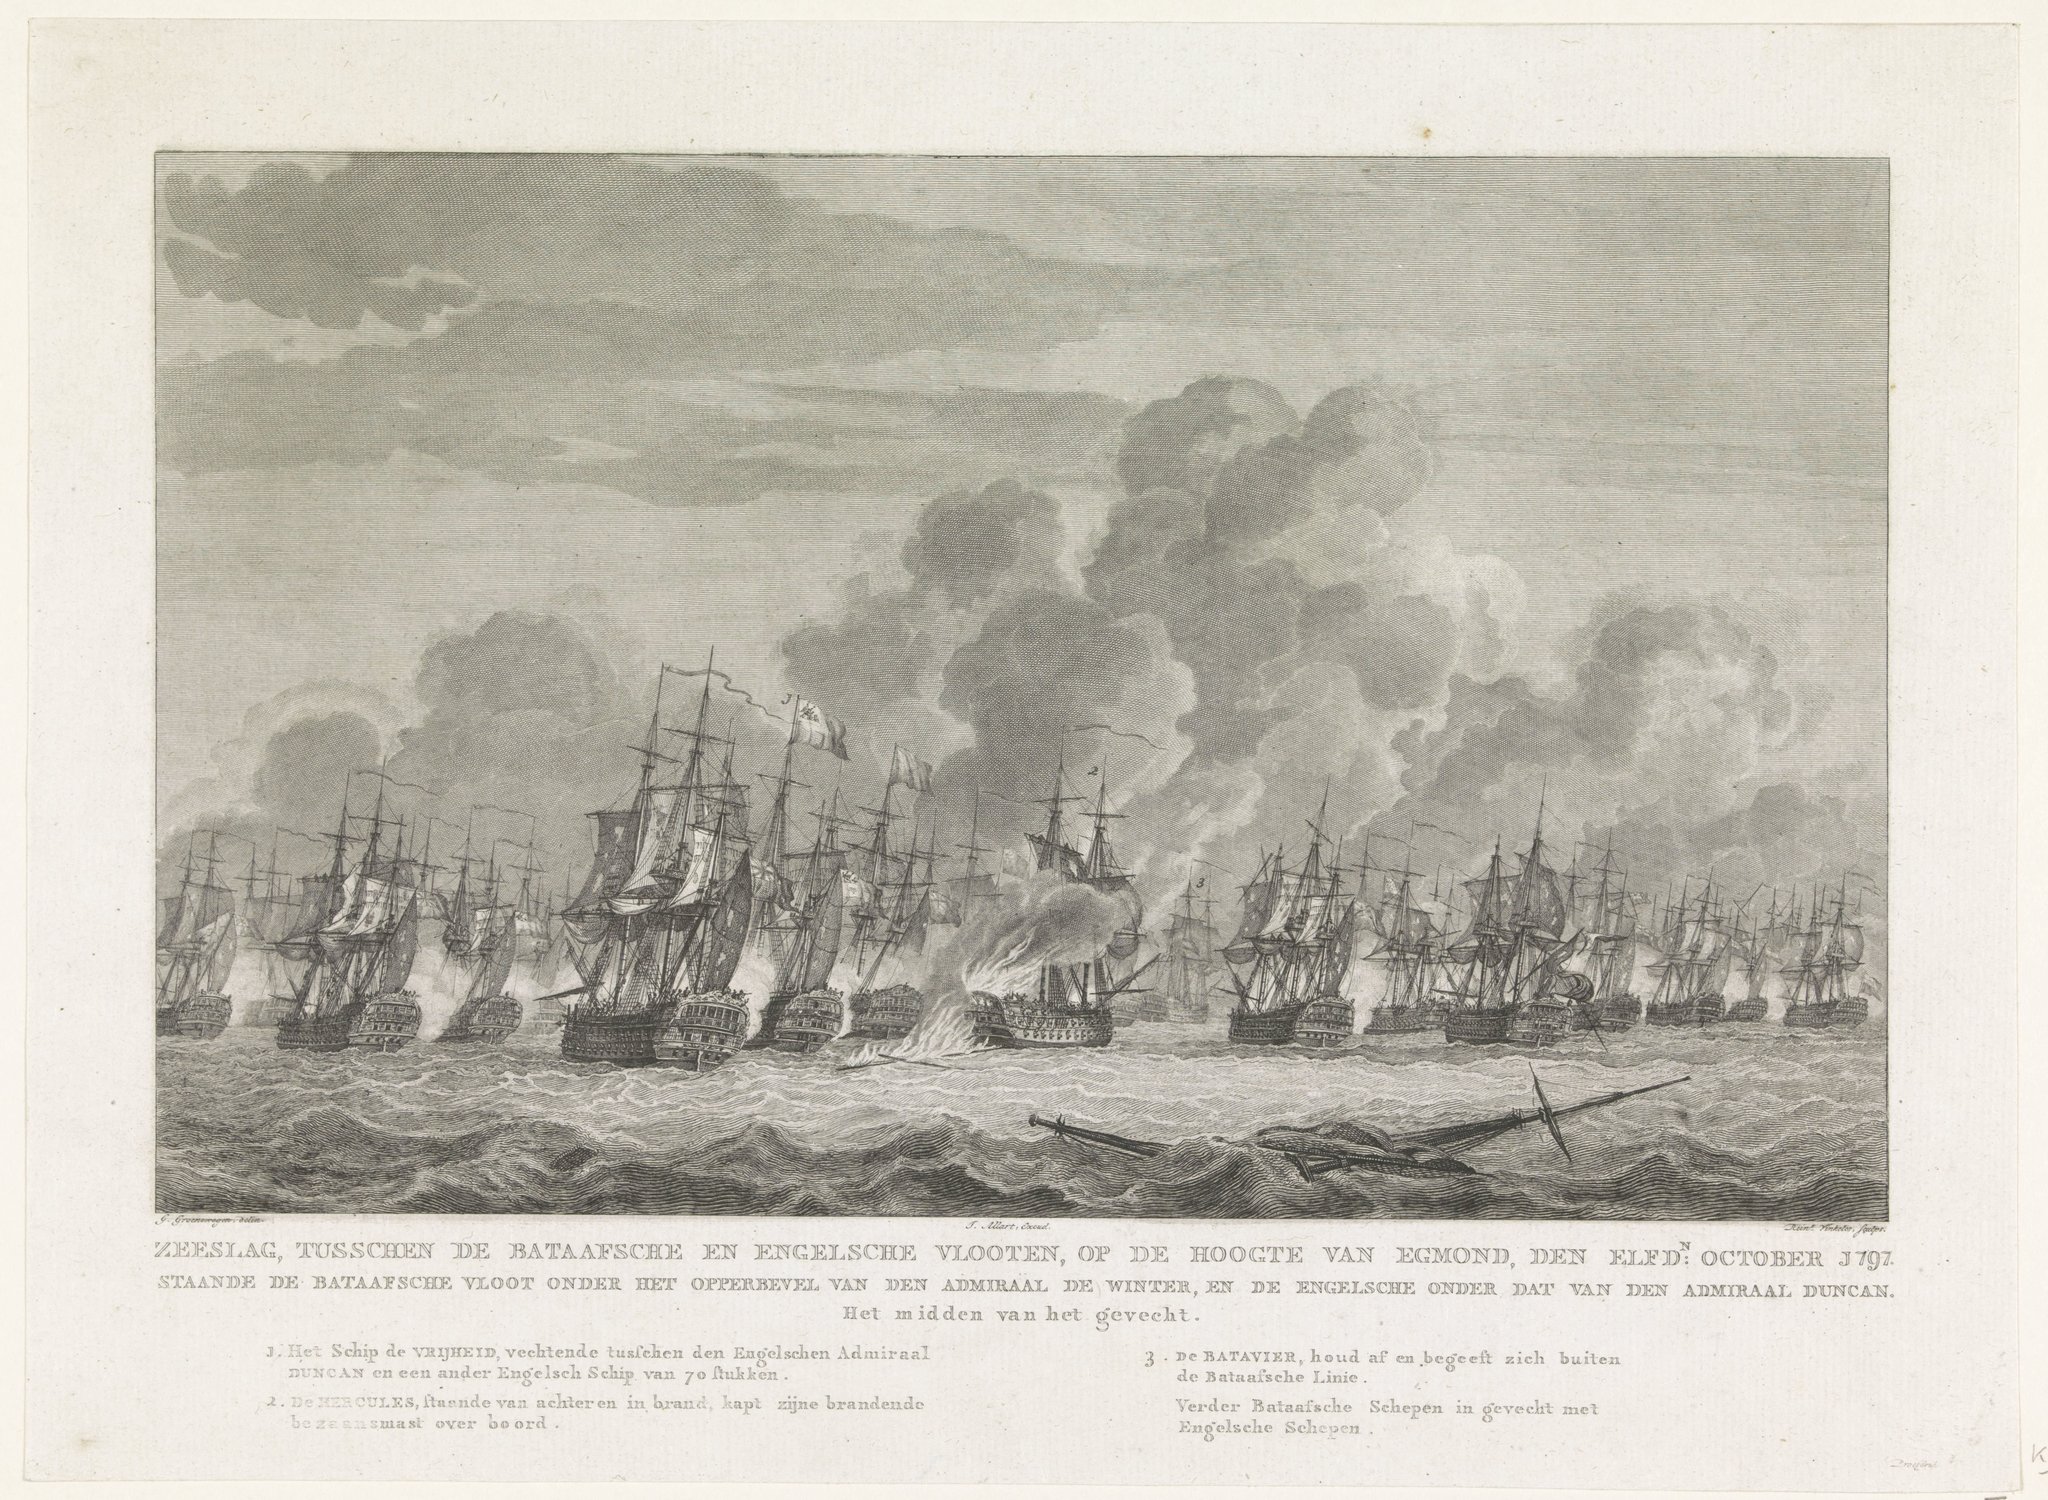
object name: print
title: Zeeslag, tusschen de Bataafsche en Engelsche Vlooten, op de hoogte van Egmond, den elfd.n october 1797 (...) Het midden van het gevecht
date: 1798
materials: paper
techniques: engraving, etching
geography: netherlands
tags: paris, jan willem de winter, battle (+ naval force), battle of camperdown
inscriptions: collector's mark: Lugt 240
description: De Zeeslag bij Kamperduin op 11 oktober 1797 tussen de Bataafse vloot onder bevel van viceadmiraal Jan Willem de Winter en een Britse vloot onder admiraal Adam Duncan. Midden van de slag. Centraal de Vrijheid (dit schip onder bevel van De Winter) en de Hercules die zijn brandende bezaansmast kapt; rechts de Engelse vloot. Onder de titel de legenda 1-3.